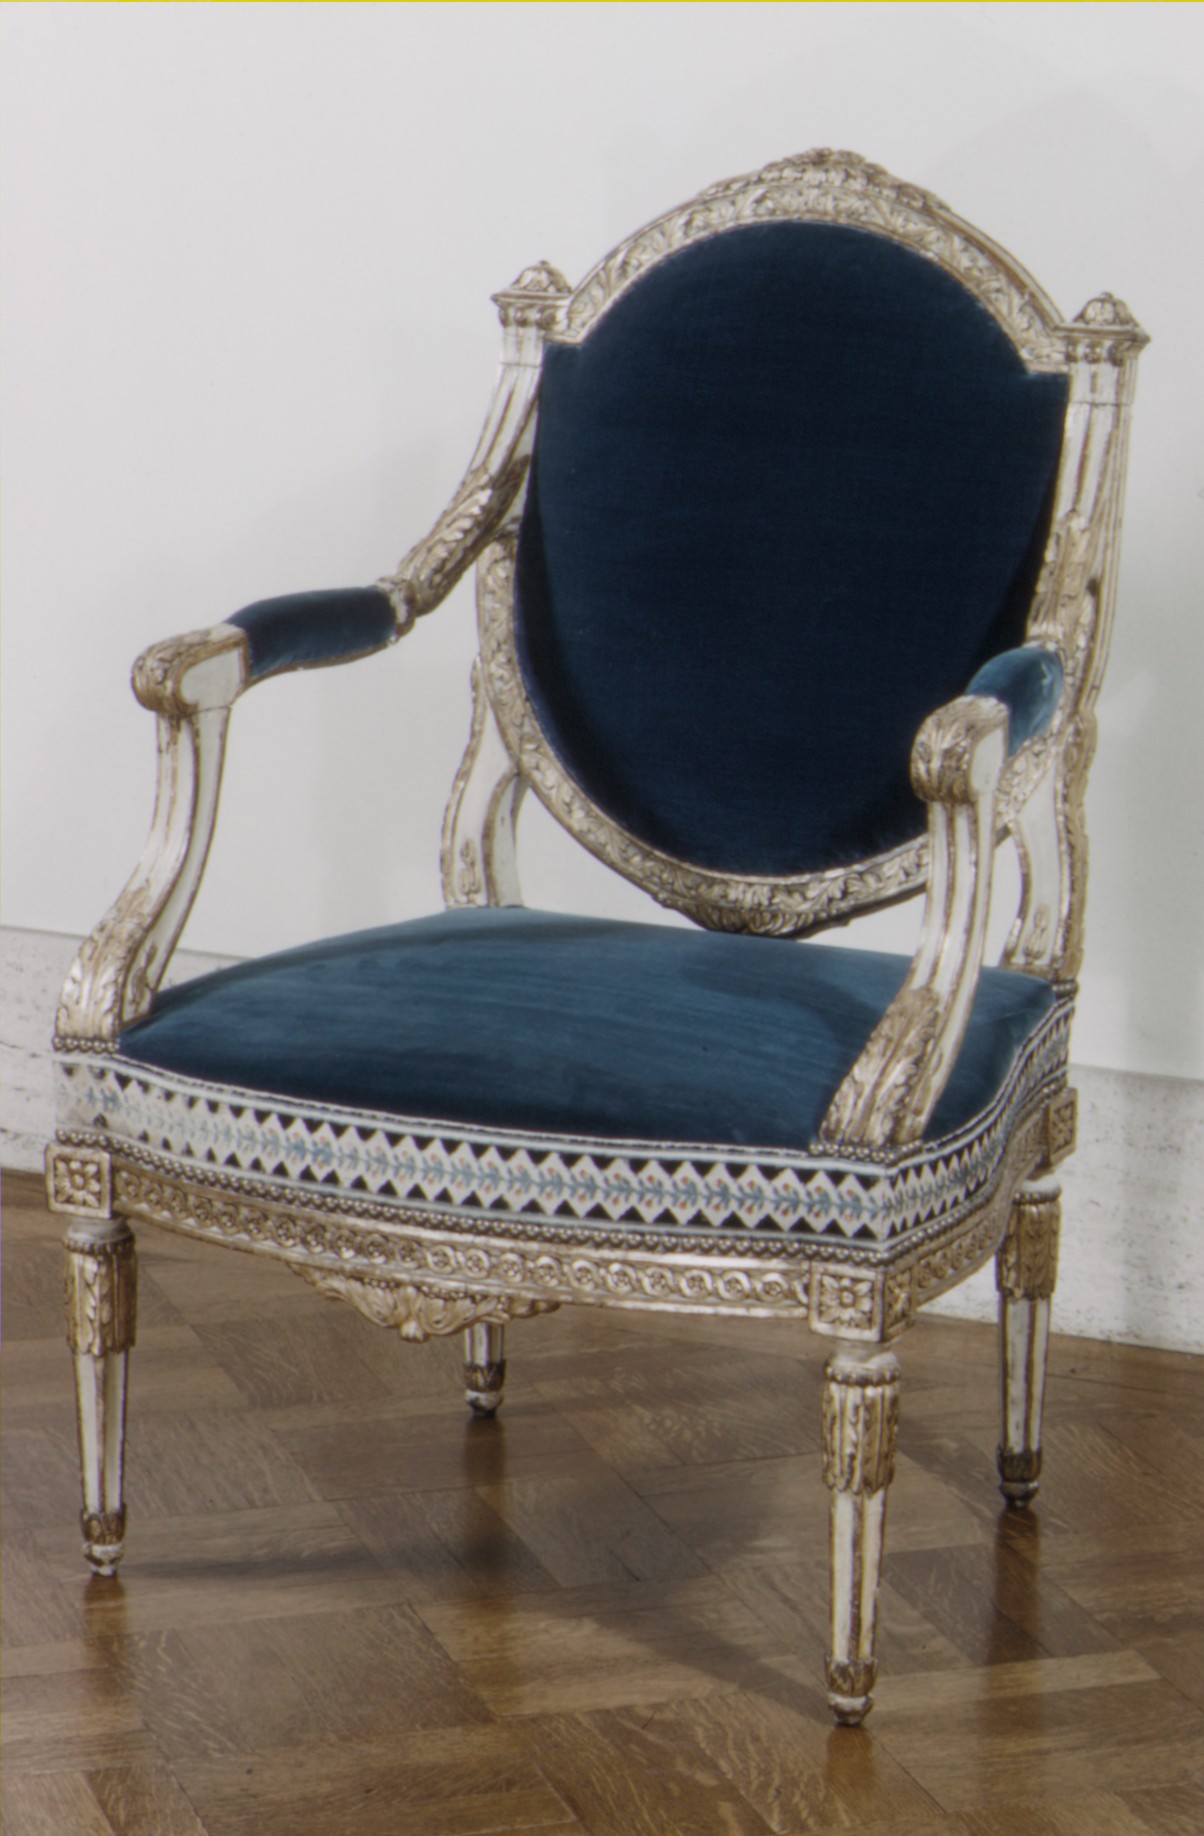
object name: armchair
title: Armchair (one of a pair)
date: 1701-1800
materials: wood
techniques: carving, gilding, painting